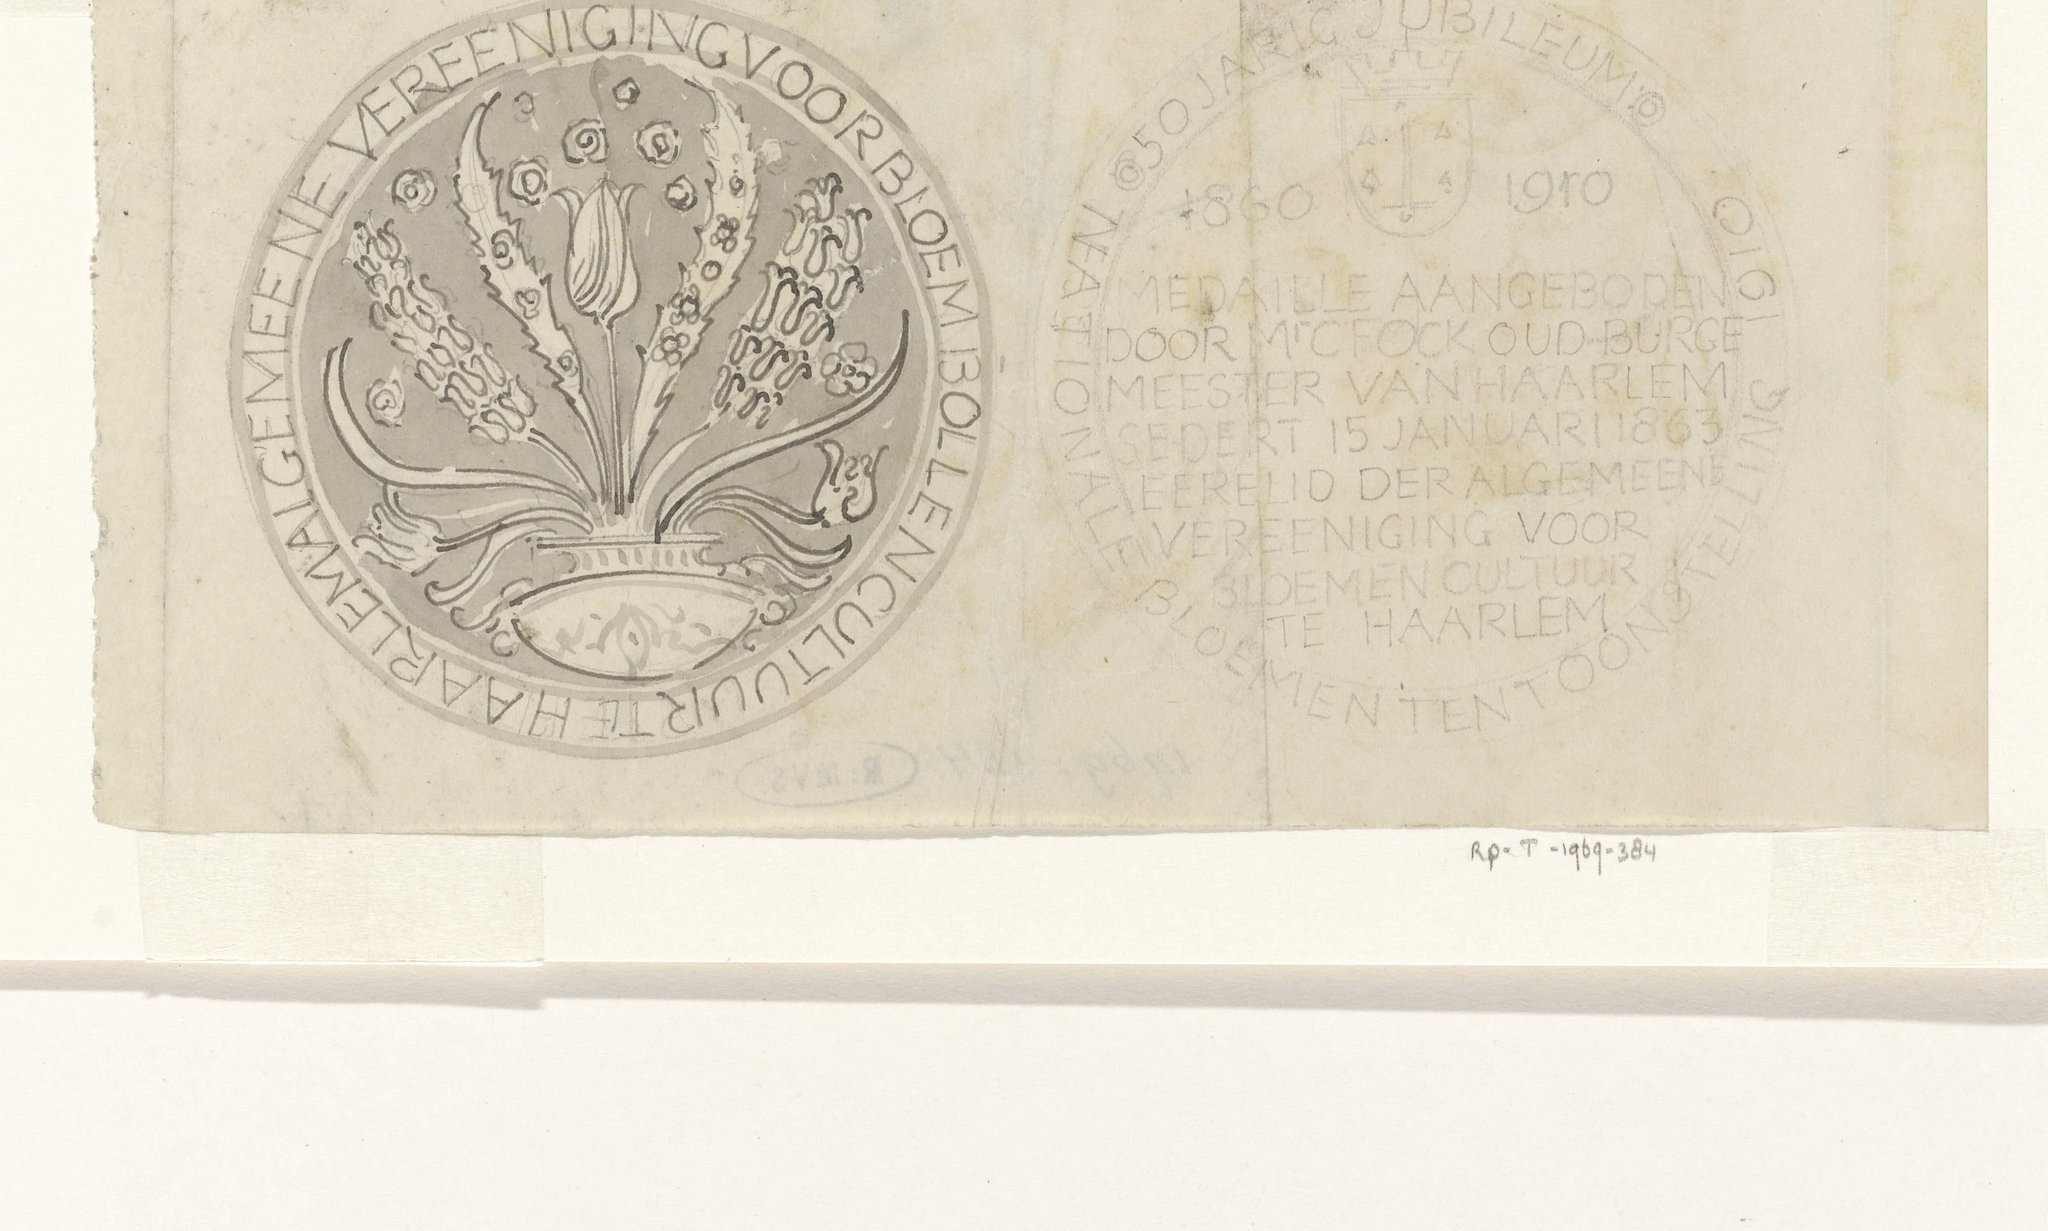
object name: drawing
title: Ontwerp voor de penning voor de Algemeene Vereeniging voor de Bloembollencultuur, 1910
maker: carel adolph lion cachet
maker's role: draughtsman, print maker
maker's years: 1864-1945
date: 1874-1945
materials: ink, paper, pencil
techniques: brush, pen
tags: names of organizations, companies, trade unions, etc., medal (considered as a piece of sculpture, regardless of its specific function)